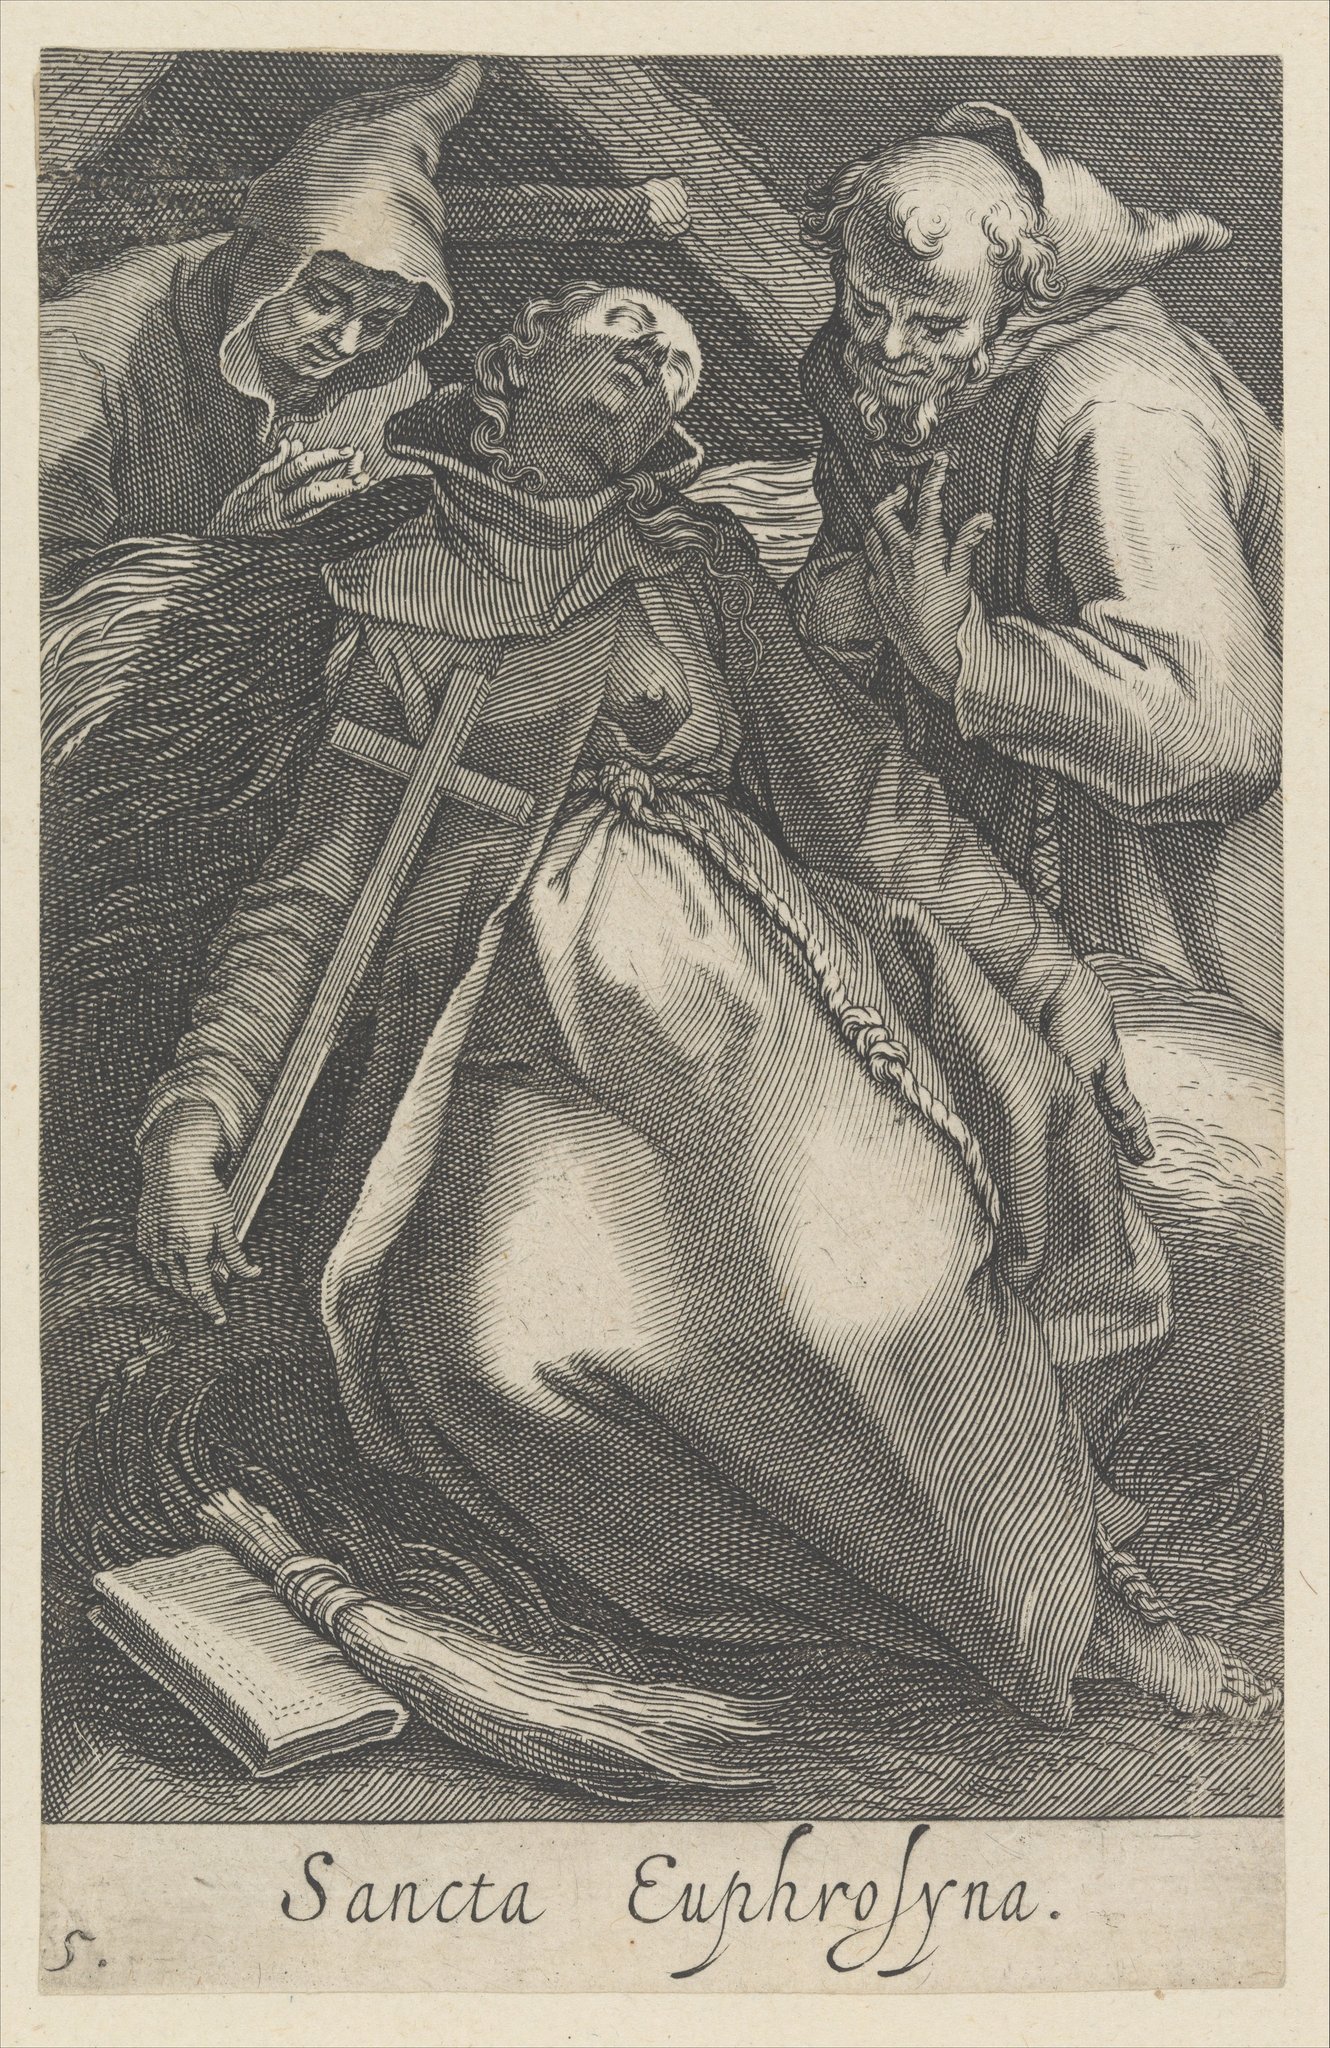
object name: print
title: Sancta Euphrolyna, from "Female Hermits"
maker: abraham bloemaert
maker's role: artist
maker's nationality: netherlandish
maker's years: 1566-1651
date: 1600-1633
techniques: engraving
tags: men,women,cross